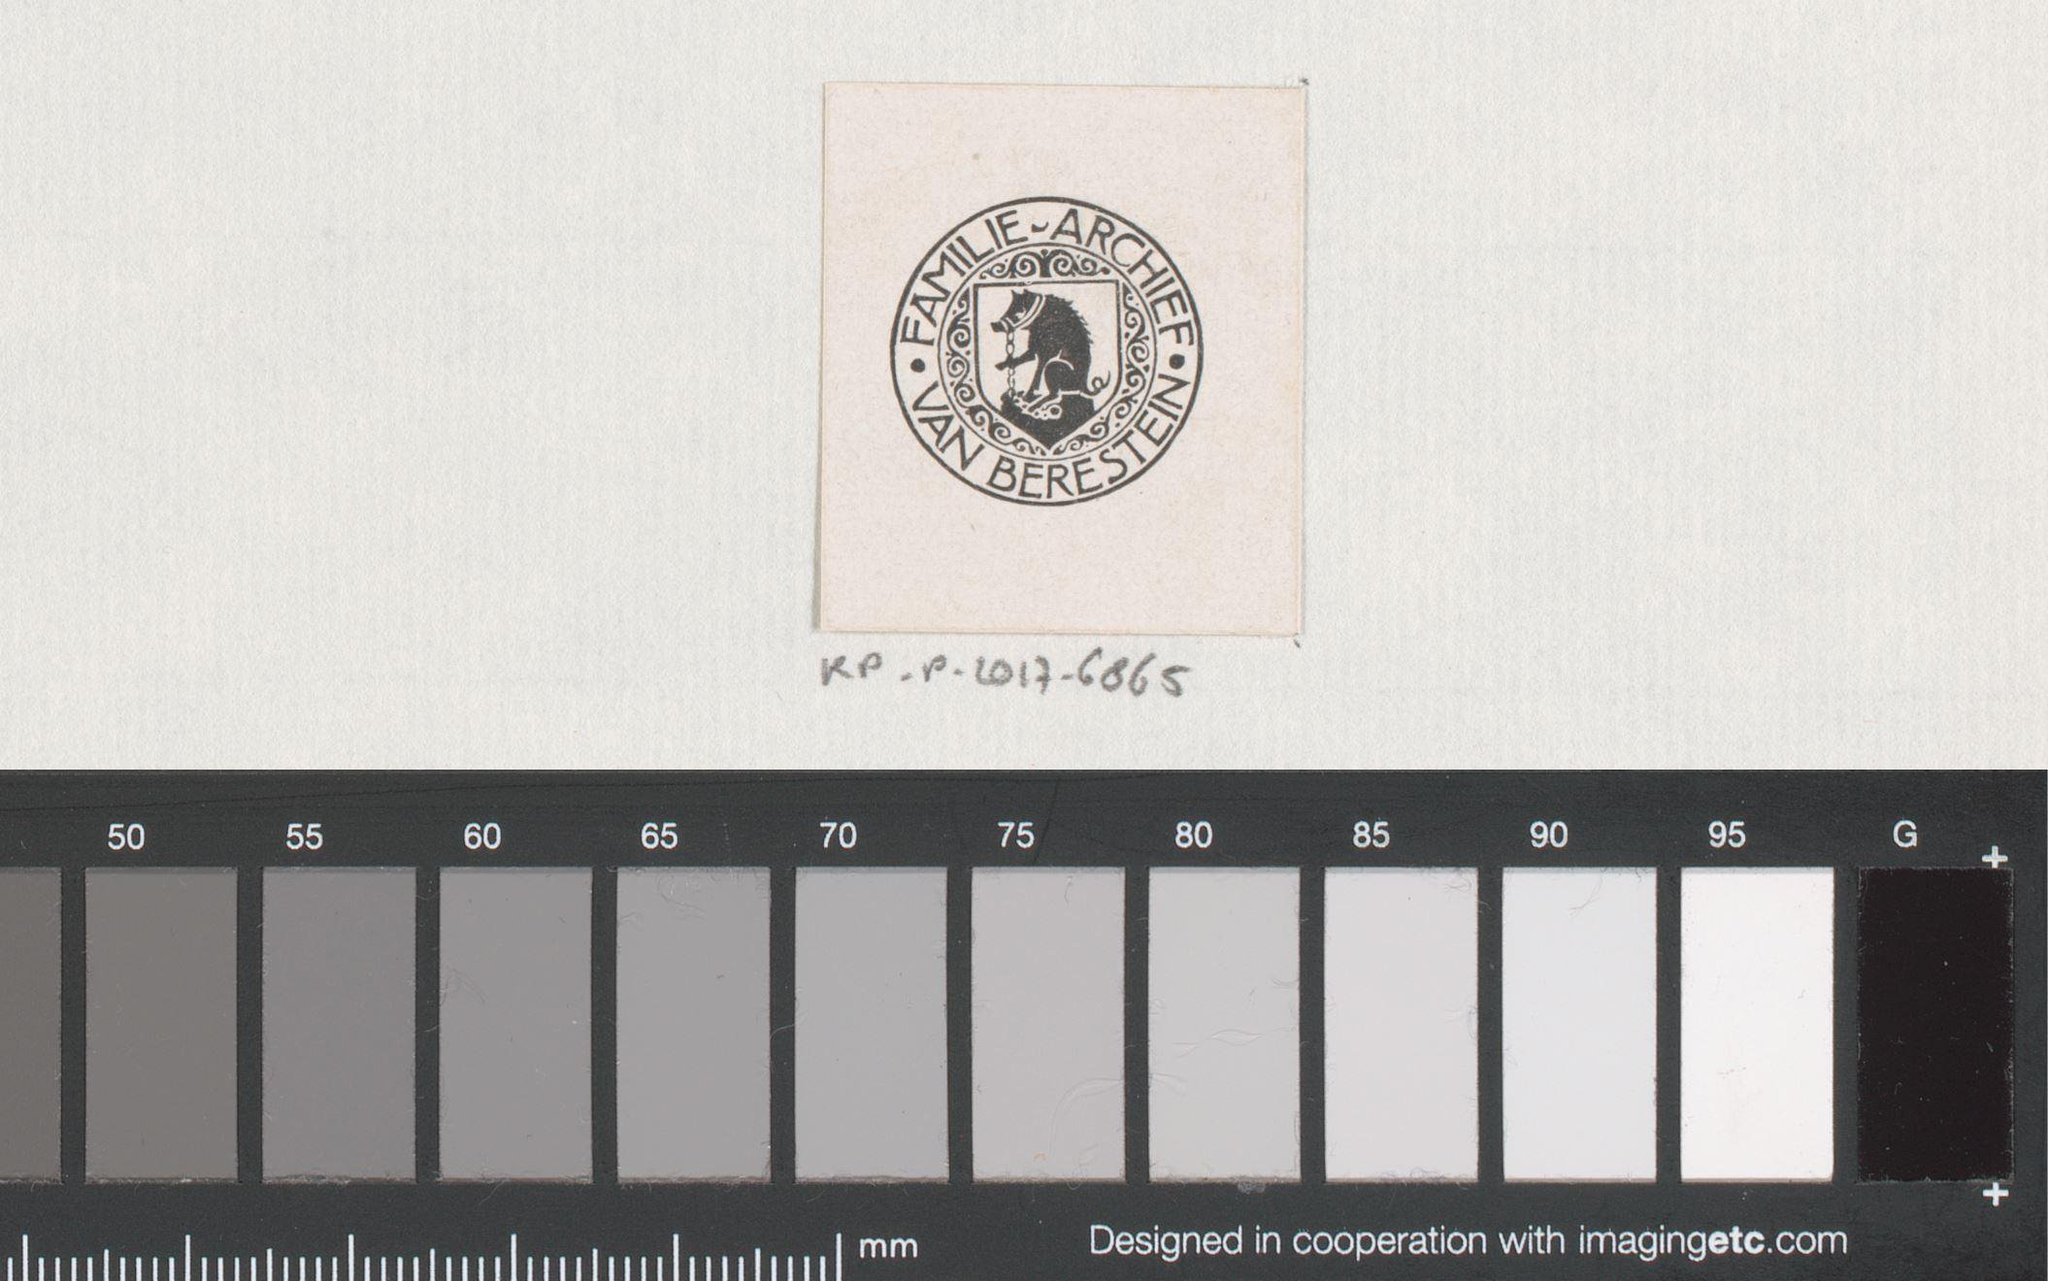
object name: bookplate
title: Ex libris van het familiearchief Van Beresteijn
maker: Anonymous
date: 1908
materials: paper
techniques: printing block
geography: netherlands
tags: haarlem, the hague, politician, eeltjo aldegondus van beresteijn, armorial bearing, heraldry